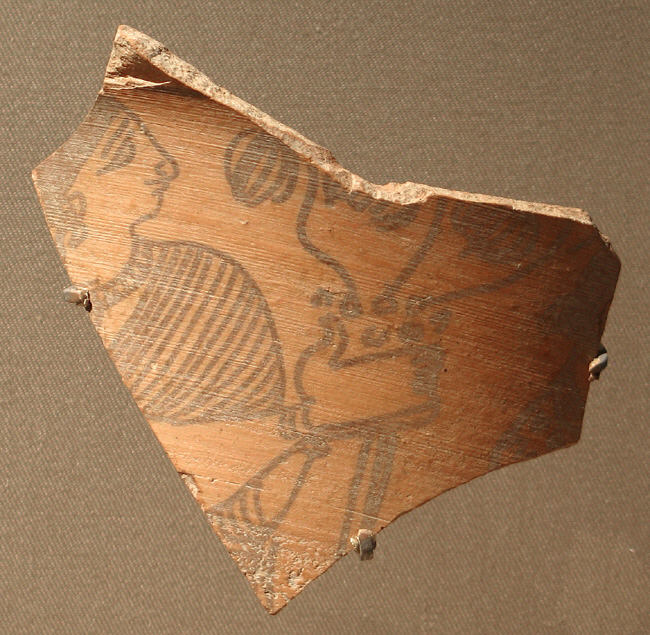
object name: shard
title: Shard with Figural Decoration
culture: pakistani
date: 301-500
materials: terracotta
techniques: painting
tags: gandhara,women